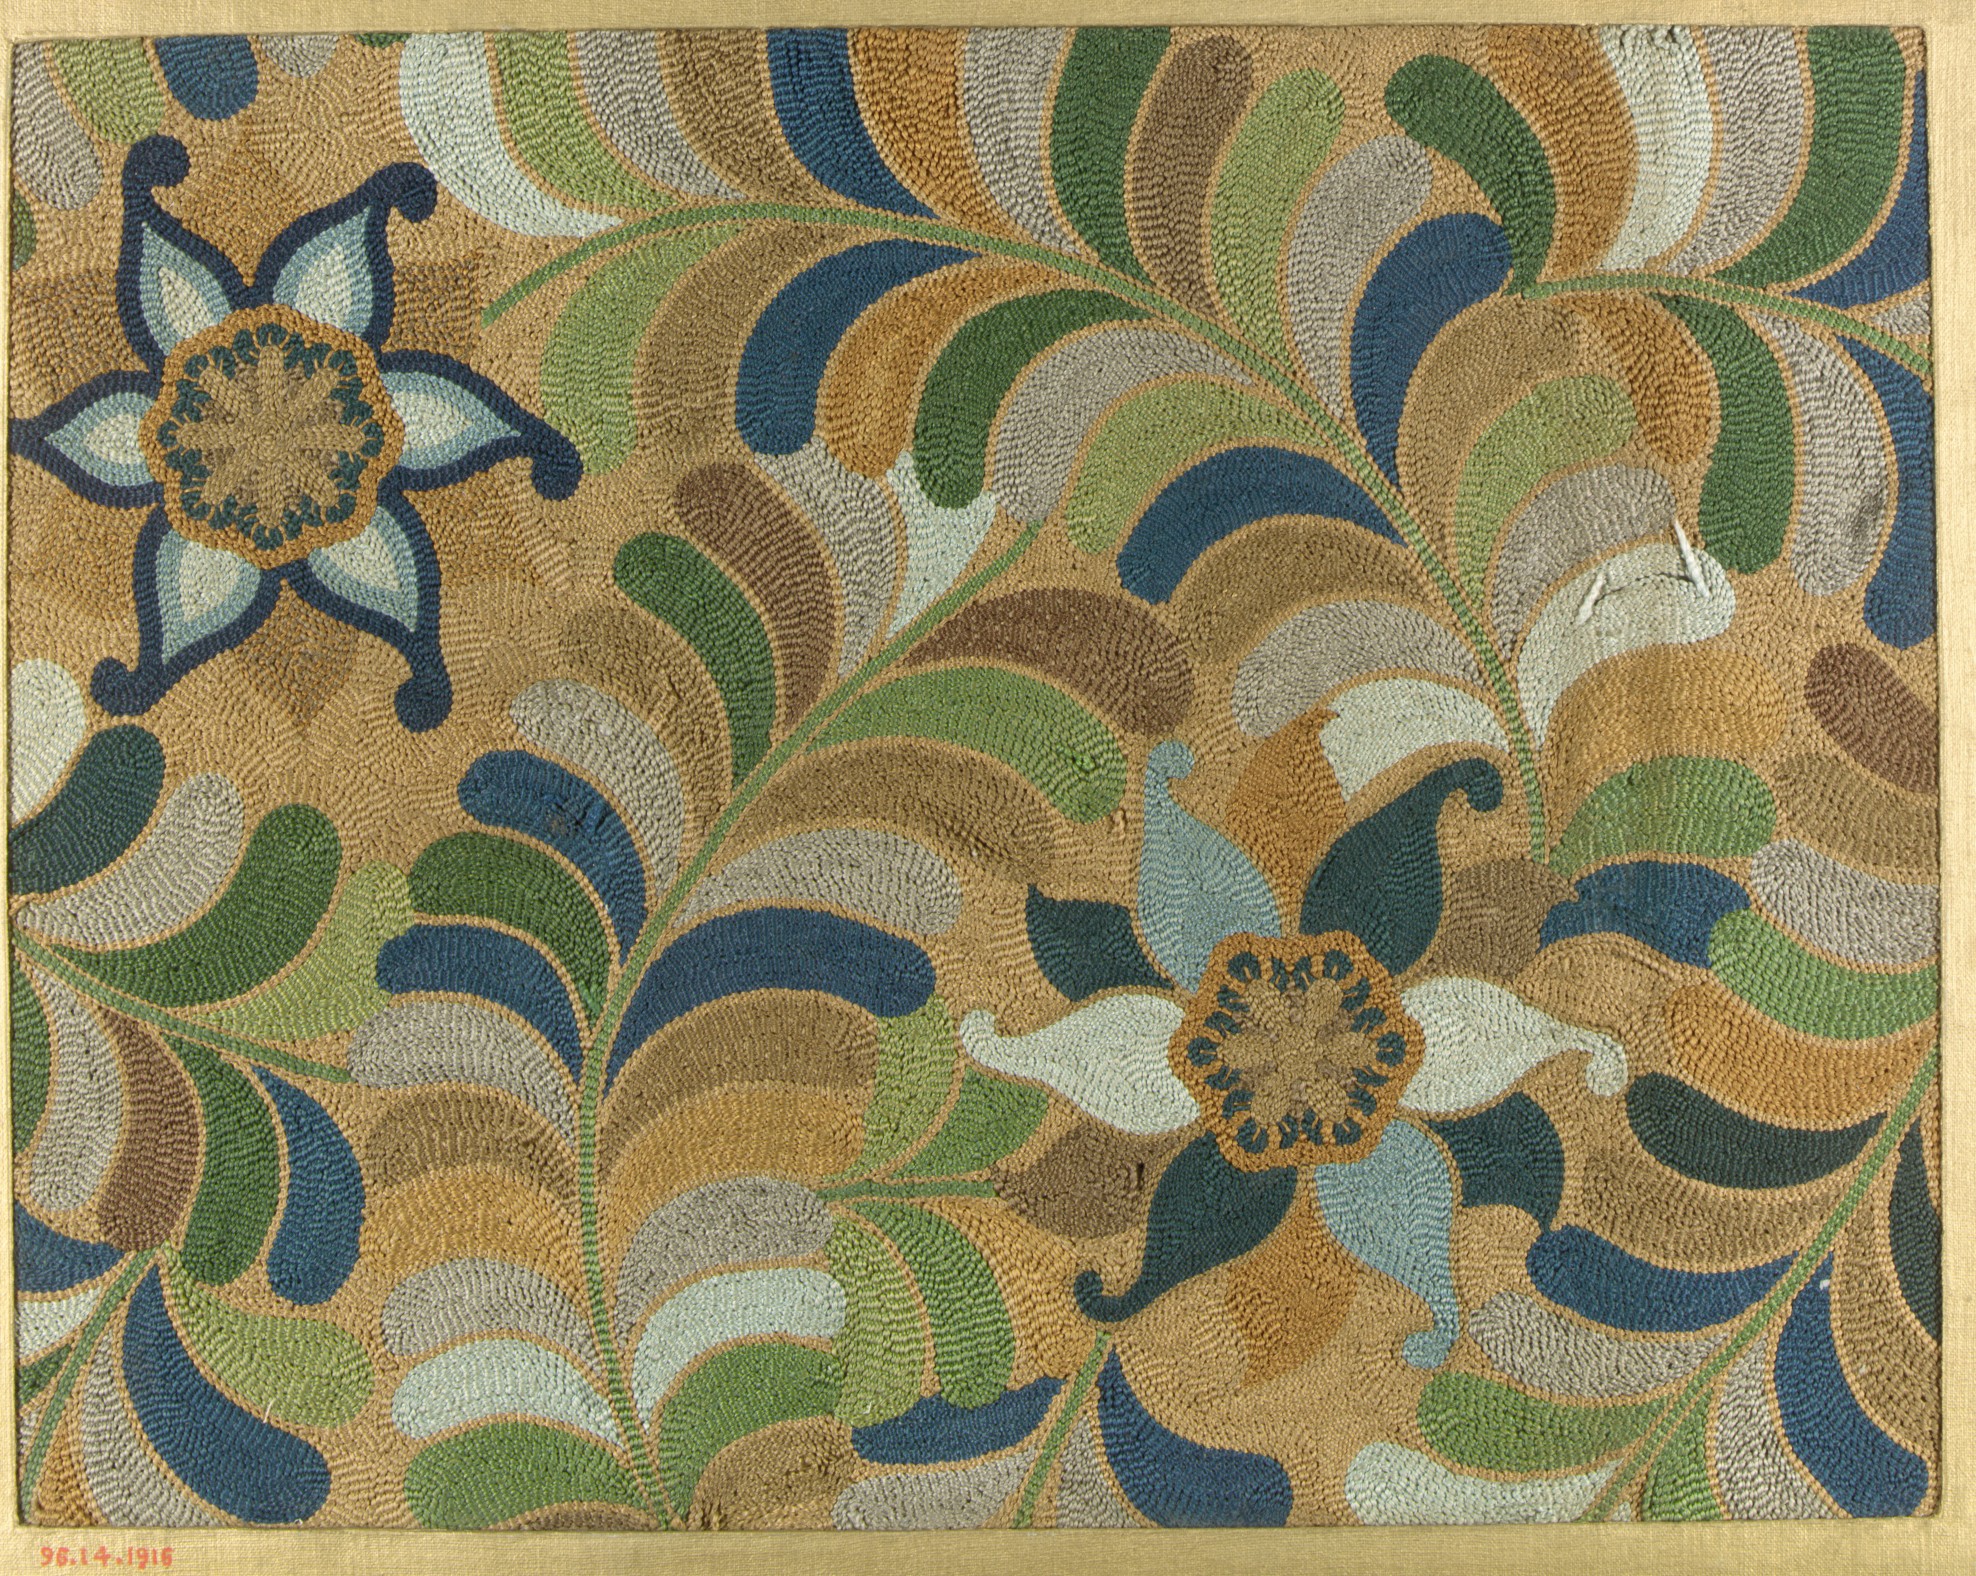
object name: piece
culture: japanese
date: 1701-1900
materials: silk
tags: flowers